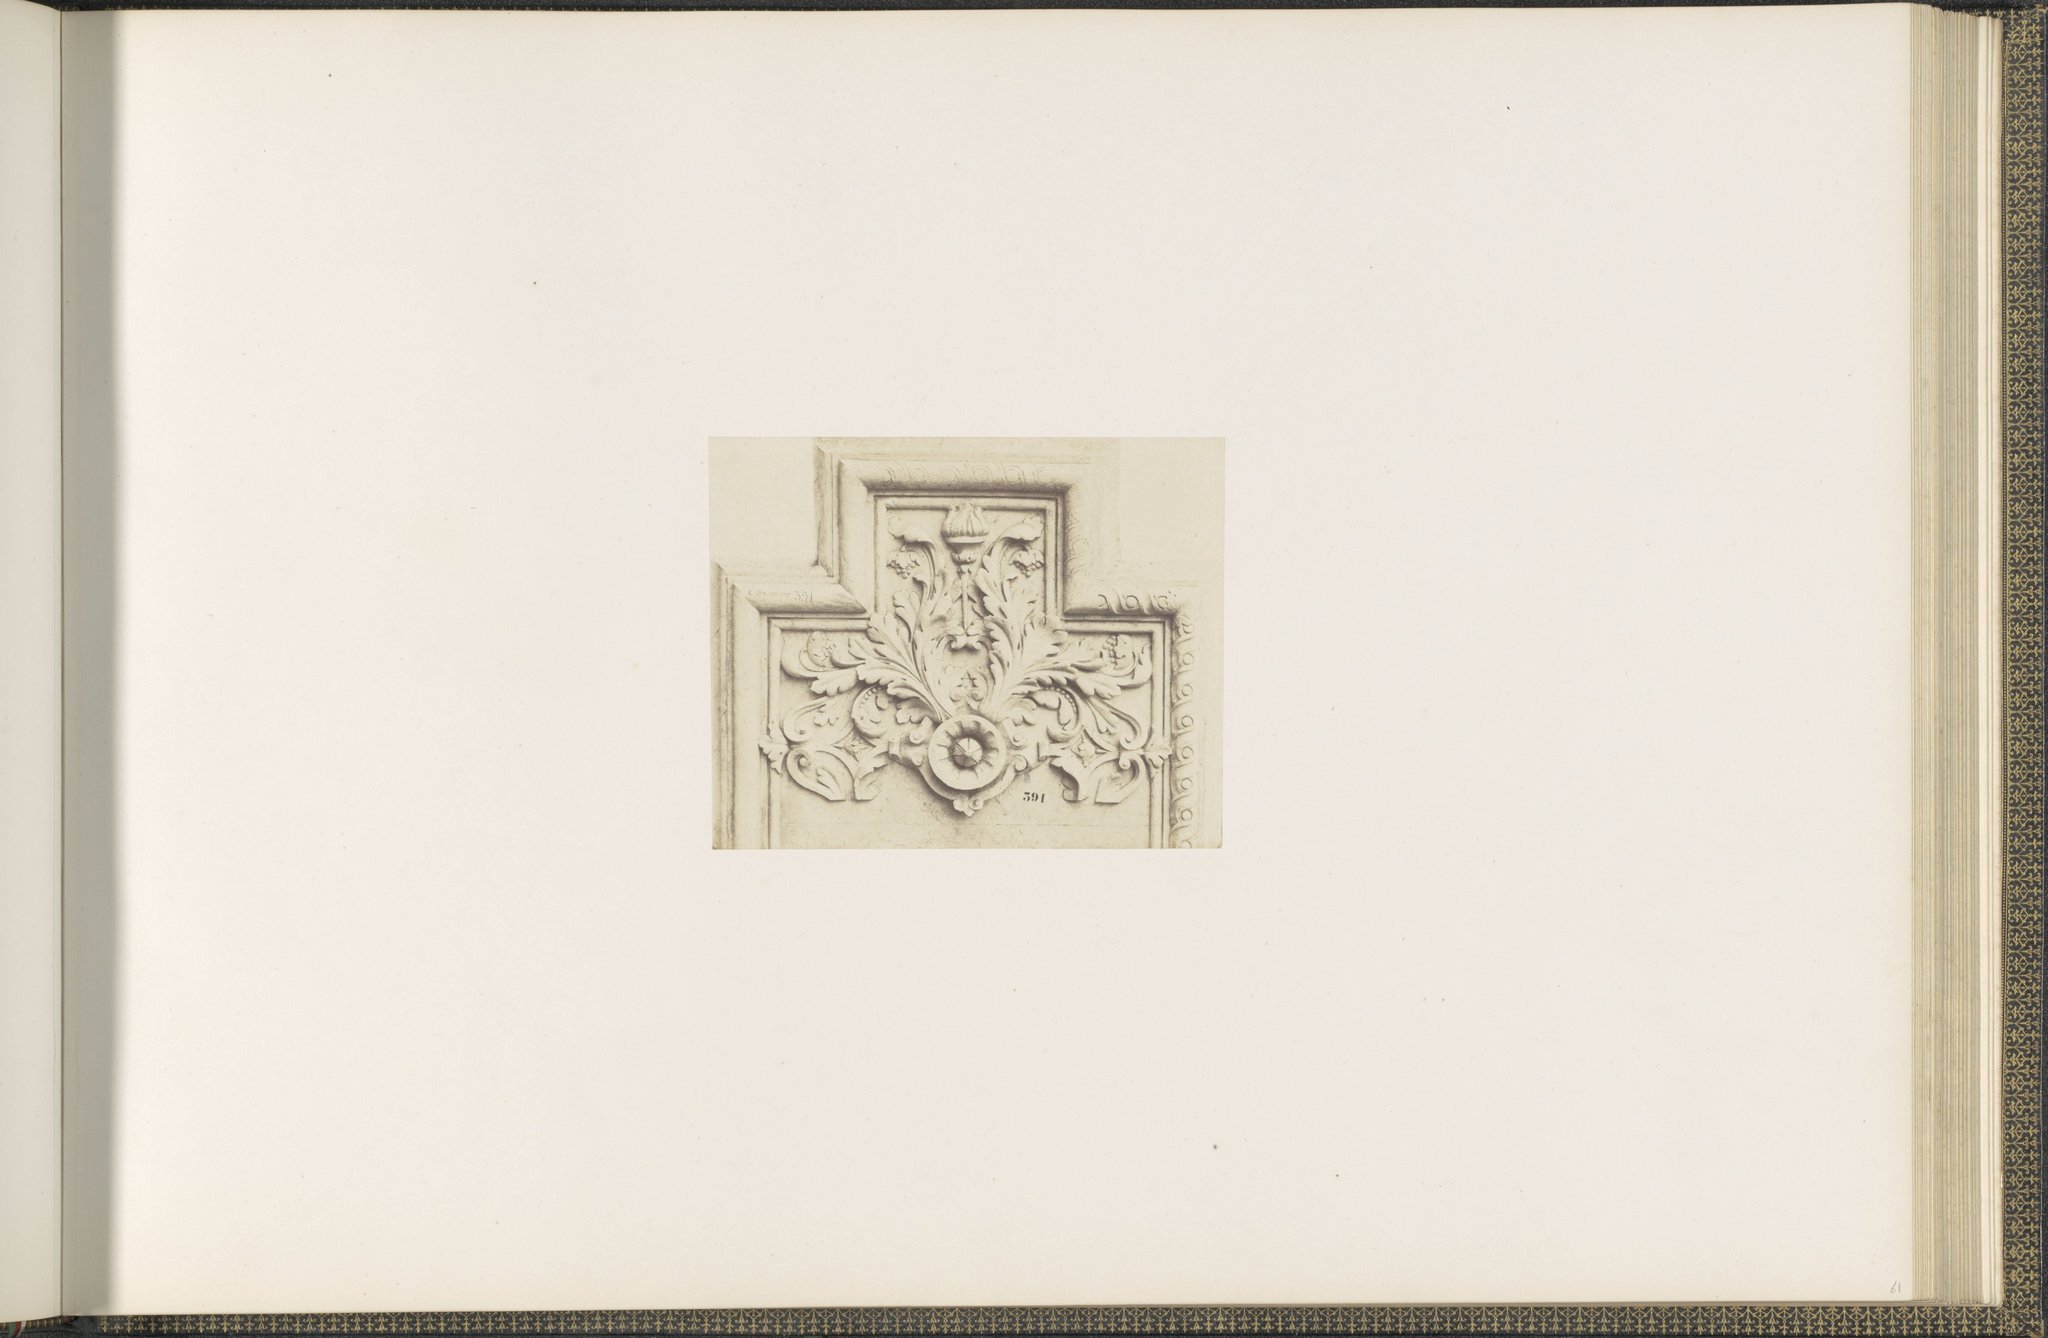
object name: photograph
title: Gipsmodel voor de versiering van het Palais du Louvre door Etienne Jacquemin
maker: édouard denis baldus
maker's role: fotograaf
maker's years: 1813-1889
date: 1855-1857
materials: paper, photographic support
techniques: salted paper print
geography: paris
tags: permanent exhibition, museum, ornamenting, decorating ~ applied arts, paris, tuileries palace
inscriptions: number: ‘391’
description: Onderdeel van Réunion des Tuileries au Louvre 1852-1857, album 4.